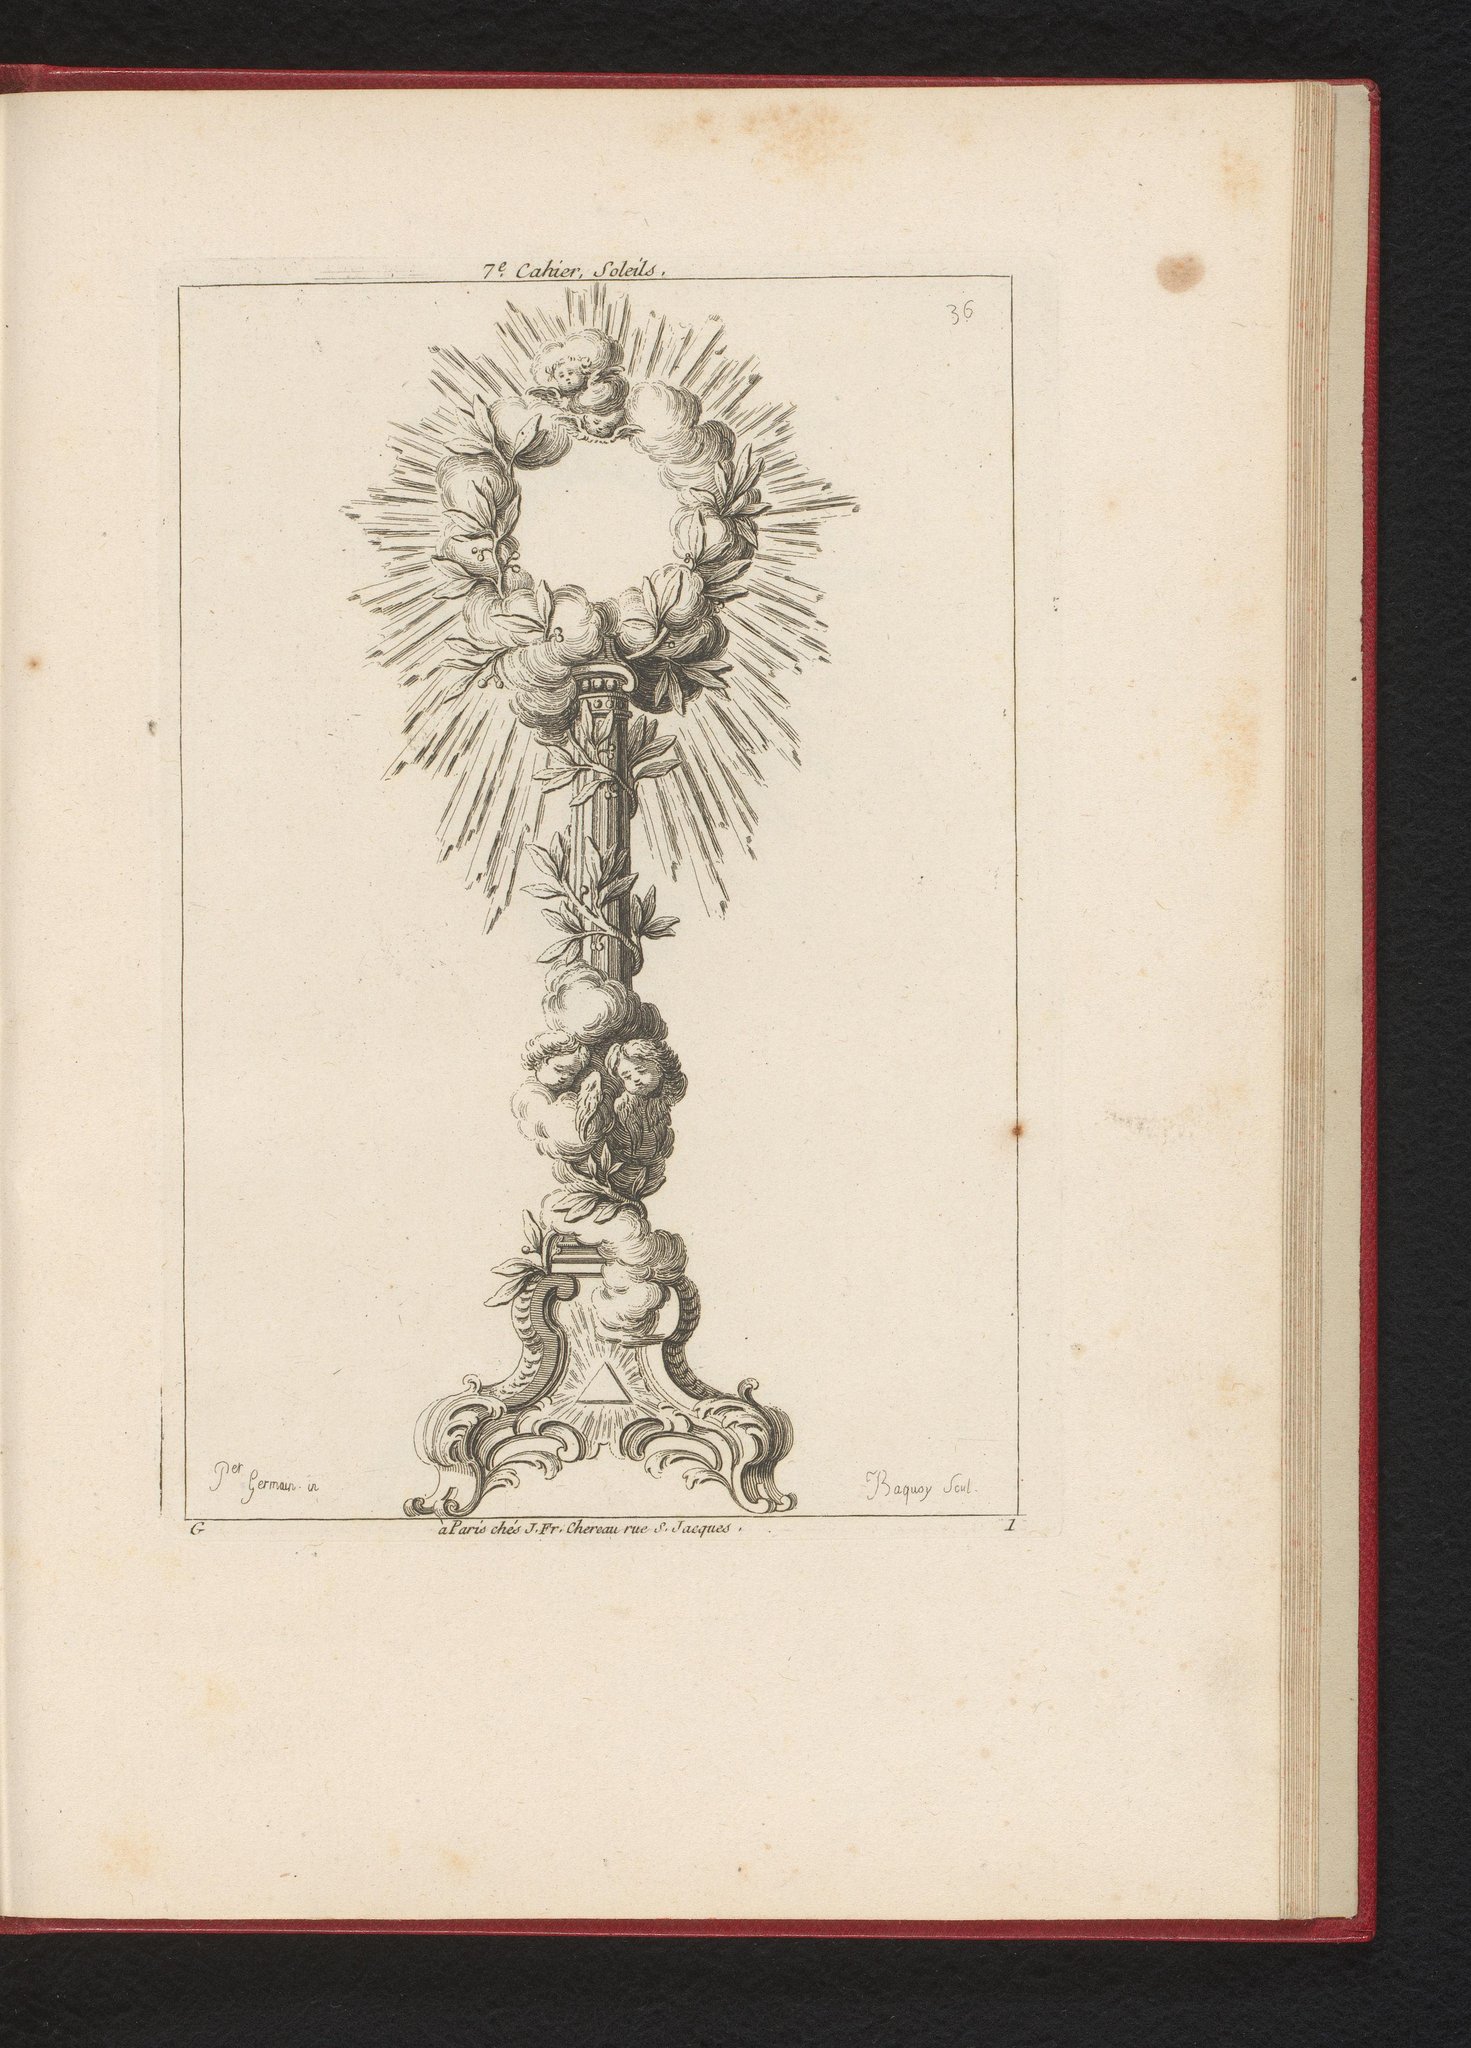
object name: album leaf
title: Ontwerp voor een zonnemonstrans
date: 1748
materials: paper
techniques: etching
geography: paris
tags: ostensorium, monstrance, jeweller, goldsmith, silversmith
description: Deze prent maakt deel uit van een album.